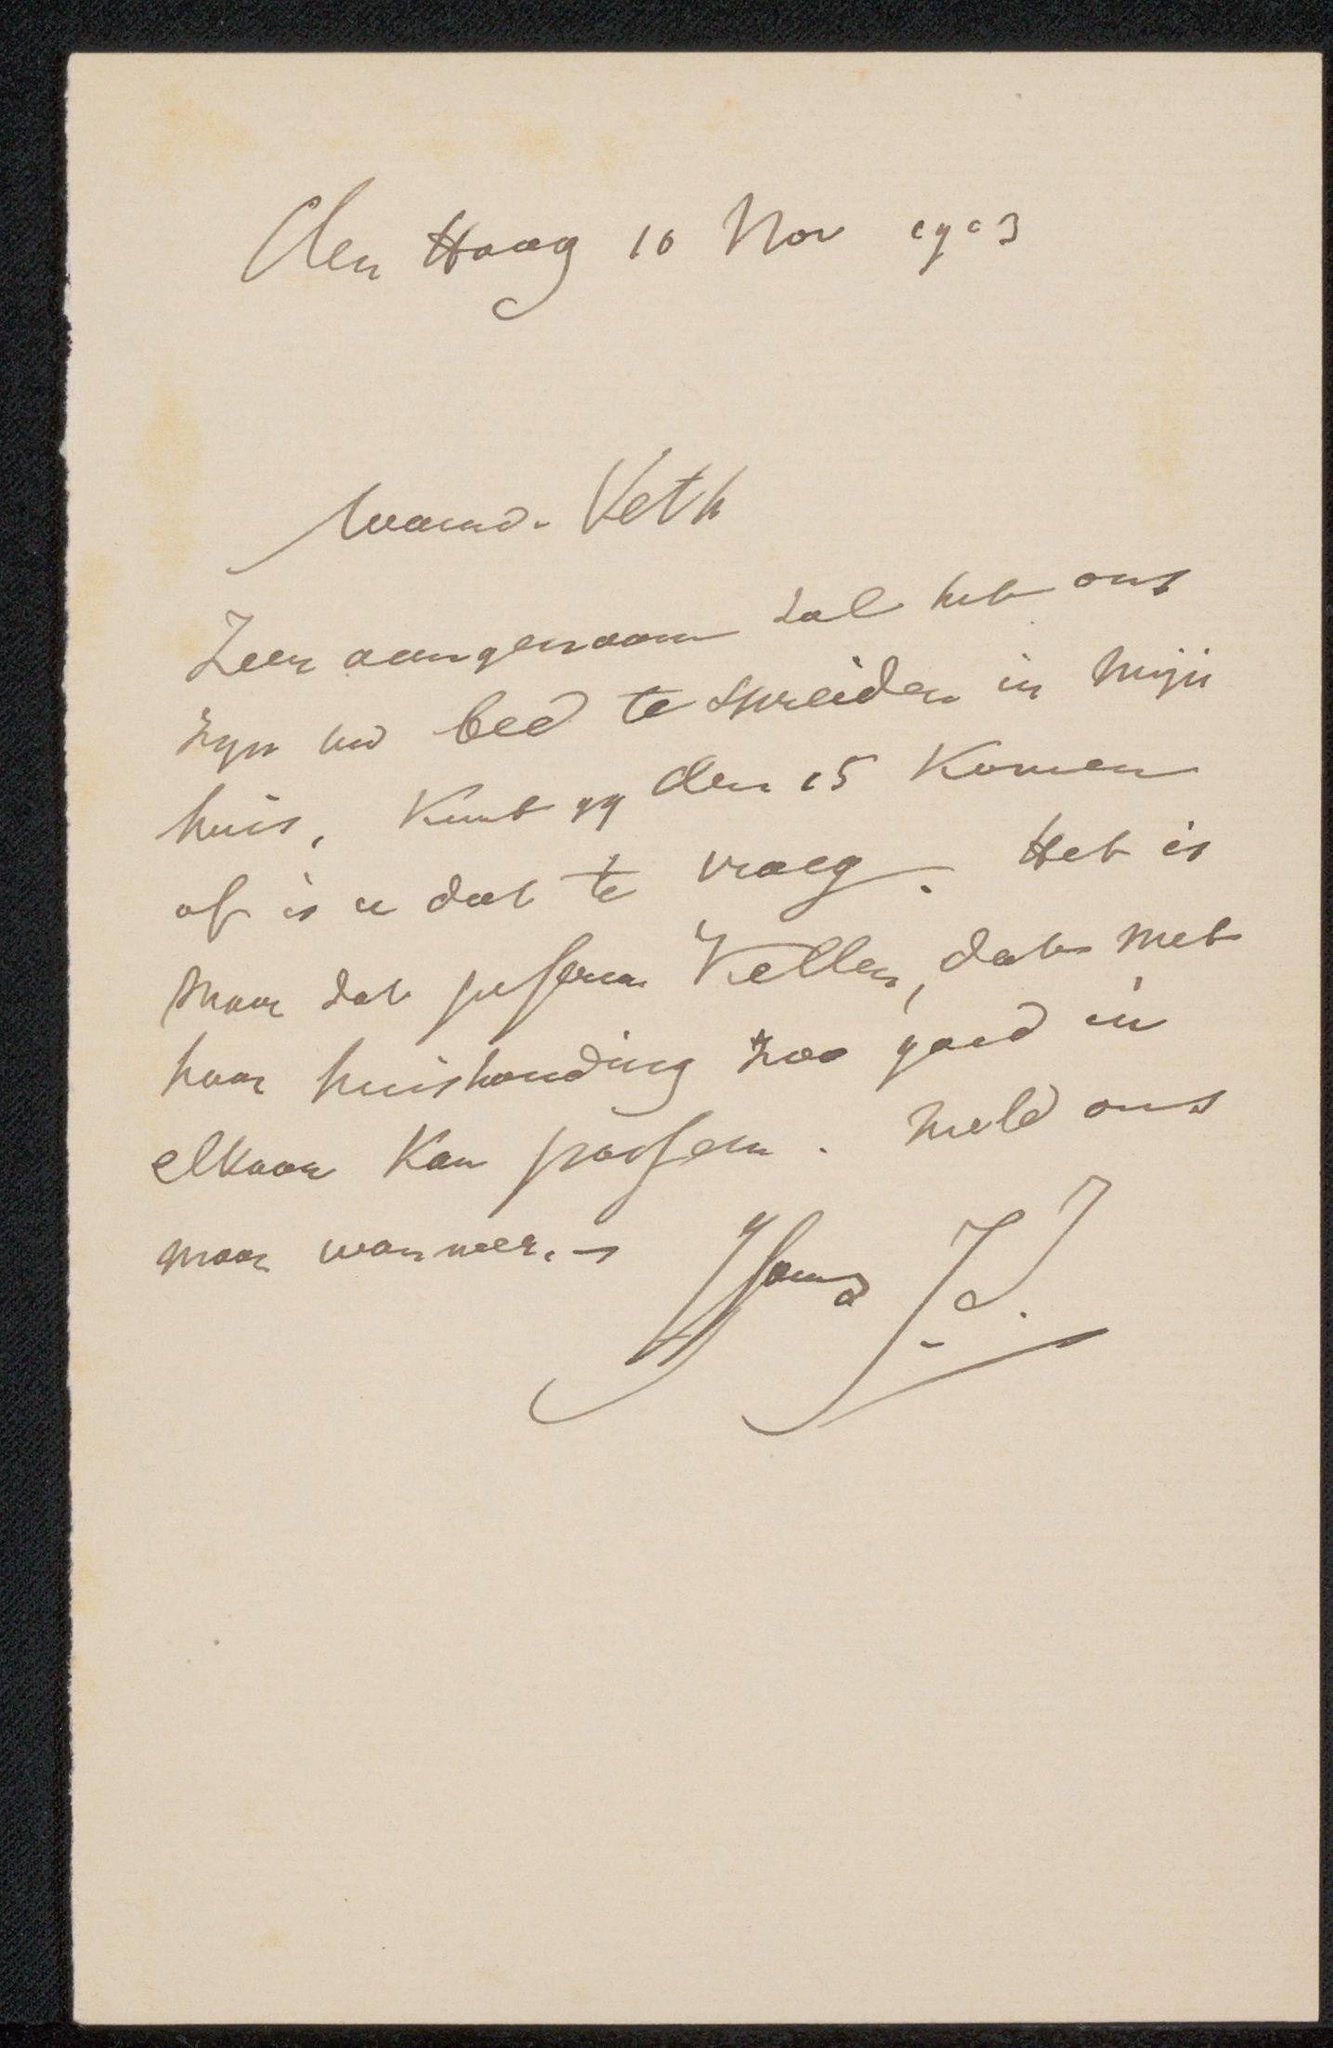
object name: letter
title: Brief aan Jan Veth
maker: jozef israëls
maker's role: draughtsman, painter, print maker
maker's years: 1824-1911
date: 1903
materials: ink, paper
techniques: pen, writing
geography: the hague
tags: dordrecht, amsterdam, painter, print maker, draughtsman, designer, jan veth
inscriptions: watermark, collector's mark: ‘RPK’